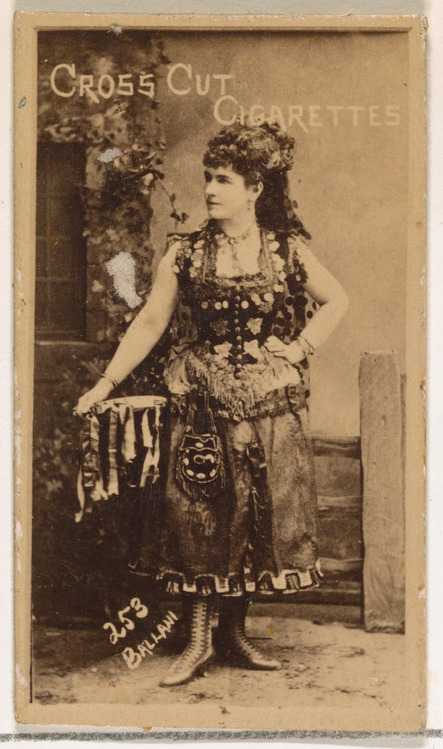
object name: print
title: Card Number 253, Ballani, from the Actors and Actresses series (N145-1) issued by Duke Sons & Co. to promote Cross Cut Cigarettes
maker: w. duke, sons & co.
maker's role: publisher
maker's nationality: american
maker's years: 1870-1920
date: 1880-1889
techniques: albumen silver print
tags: portraits,women,actresses